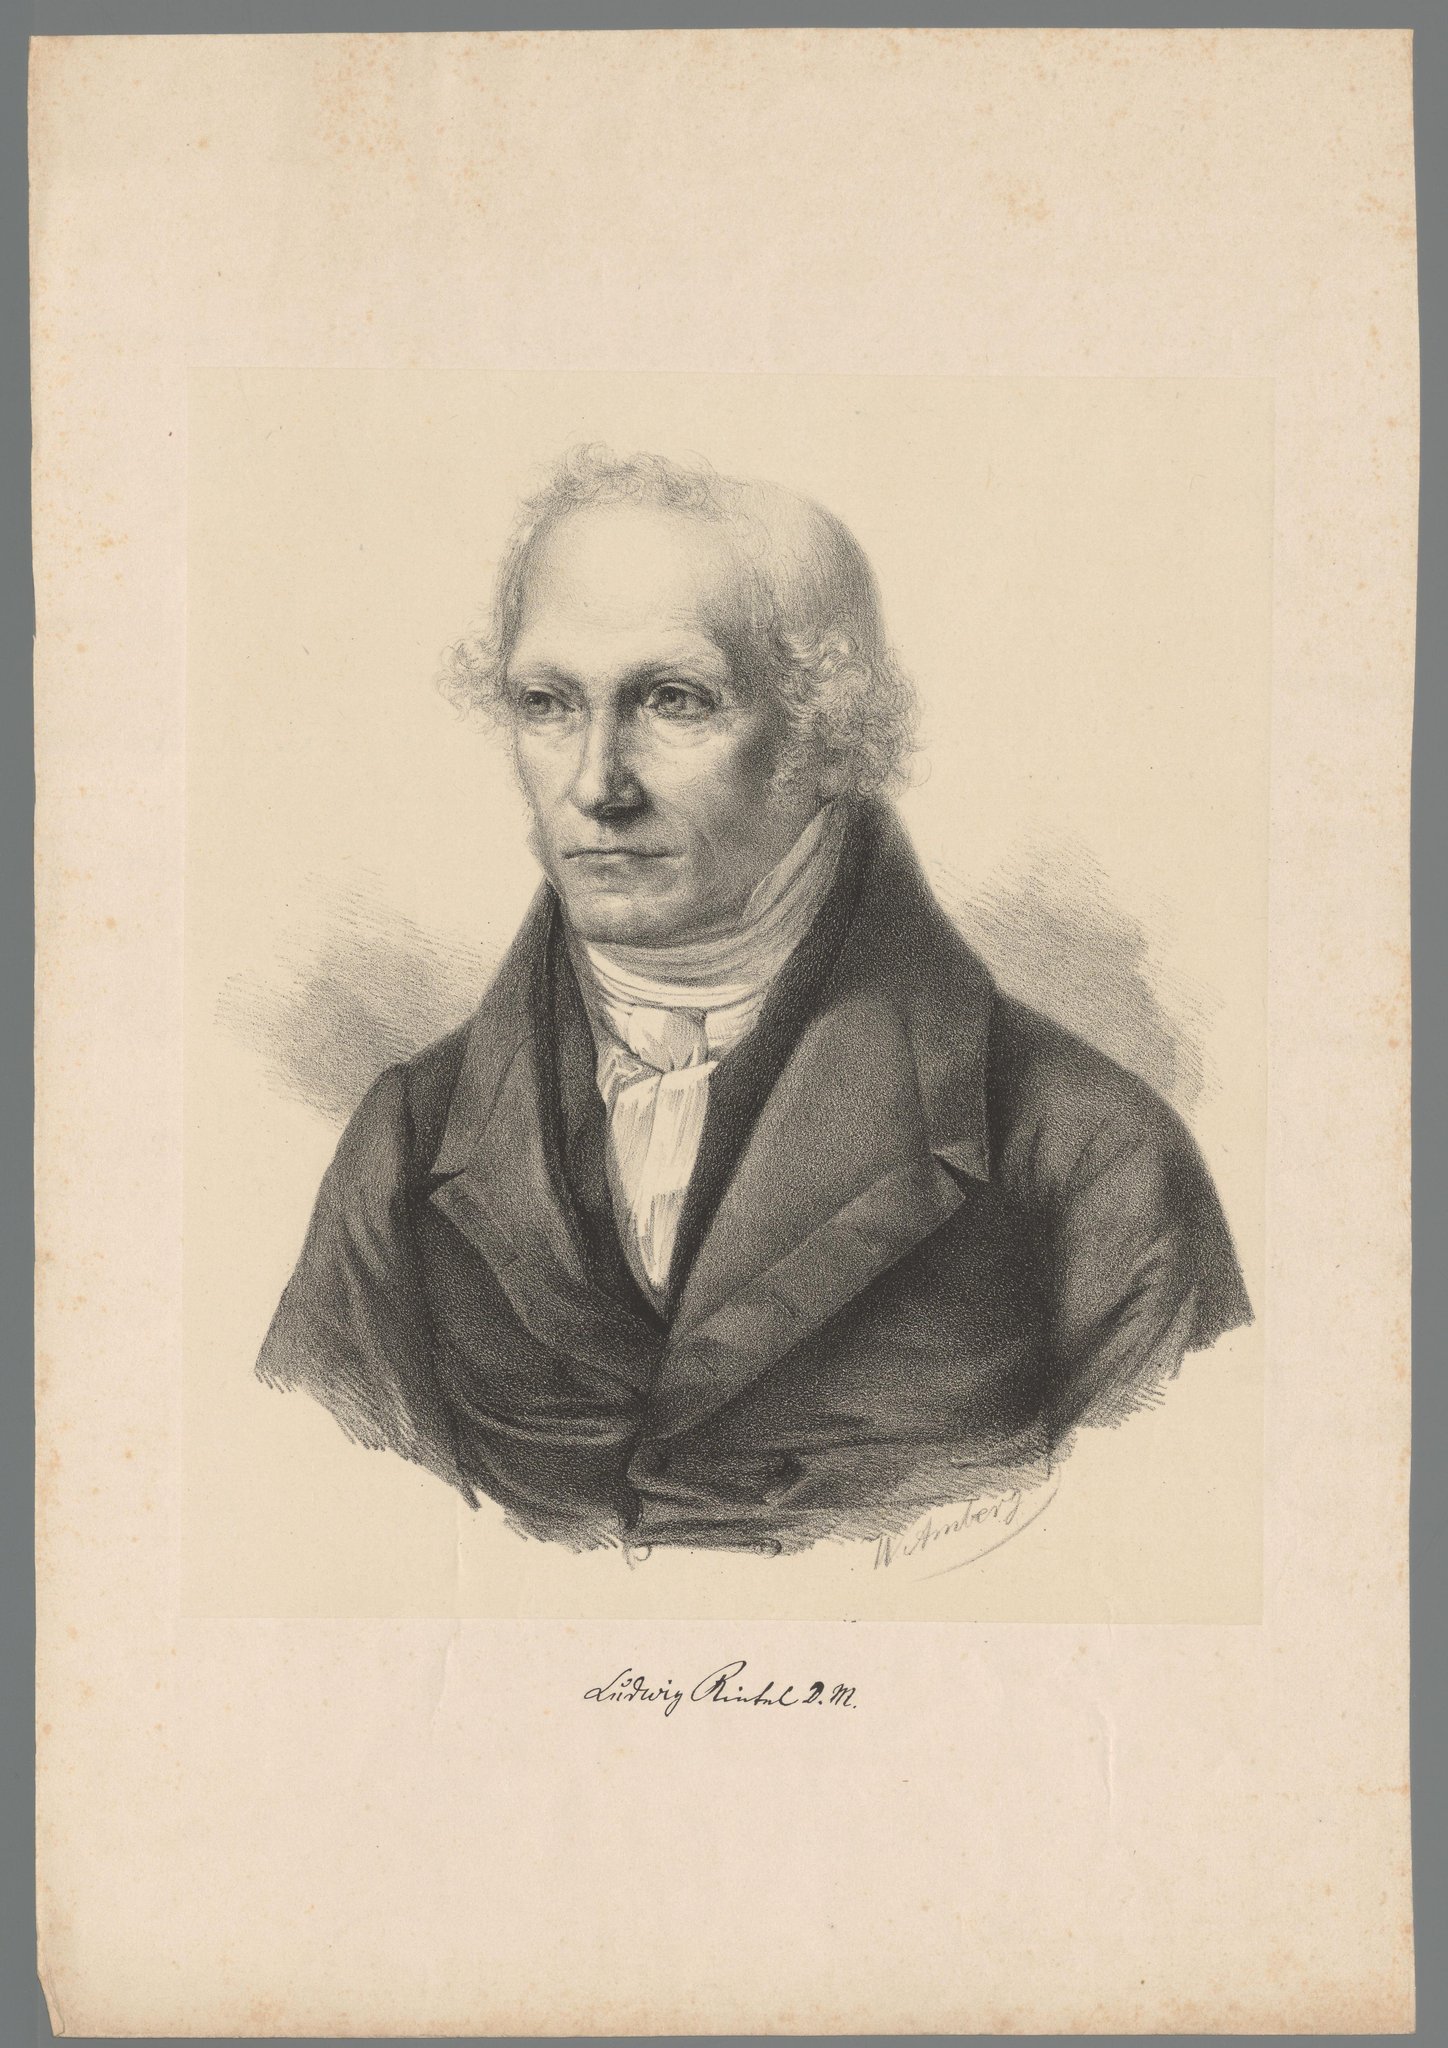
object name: print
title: Ludwig Rintel D.M.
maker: wilhelm amberg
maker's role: print maker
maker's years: 1822-1899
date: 1832-1885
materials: paper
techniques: lithography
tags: historical persons, medicine, medical science (+ portrait of scholar, scientist)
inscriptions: collector's mark: Lugt 2228